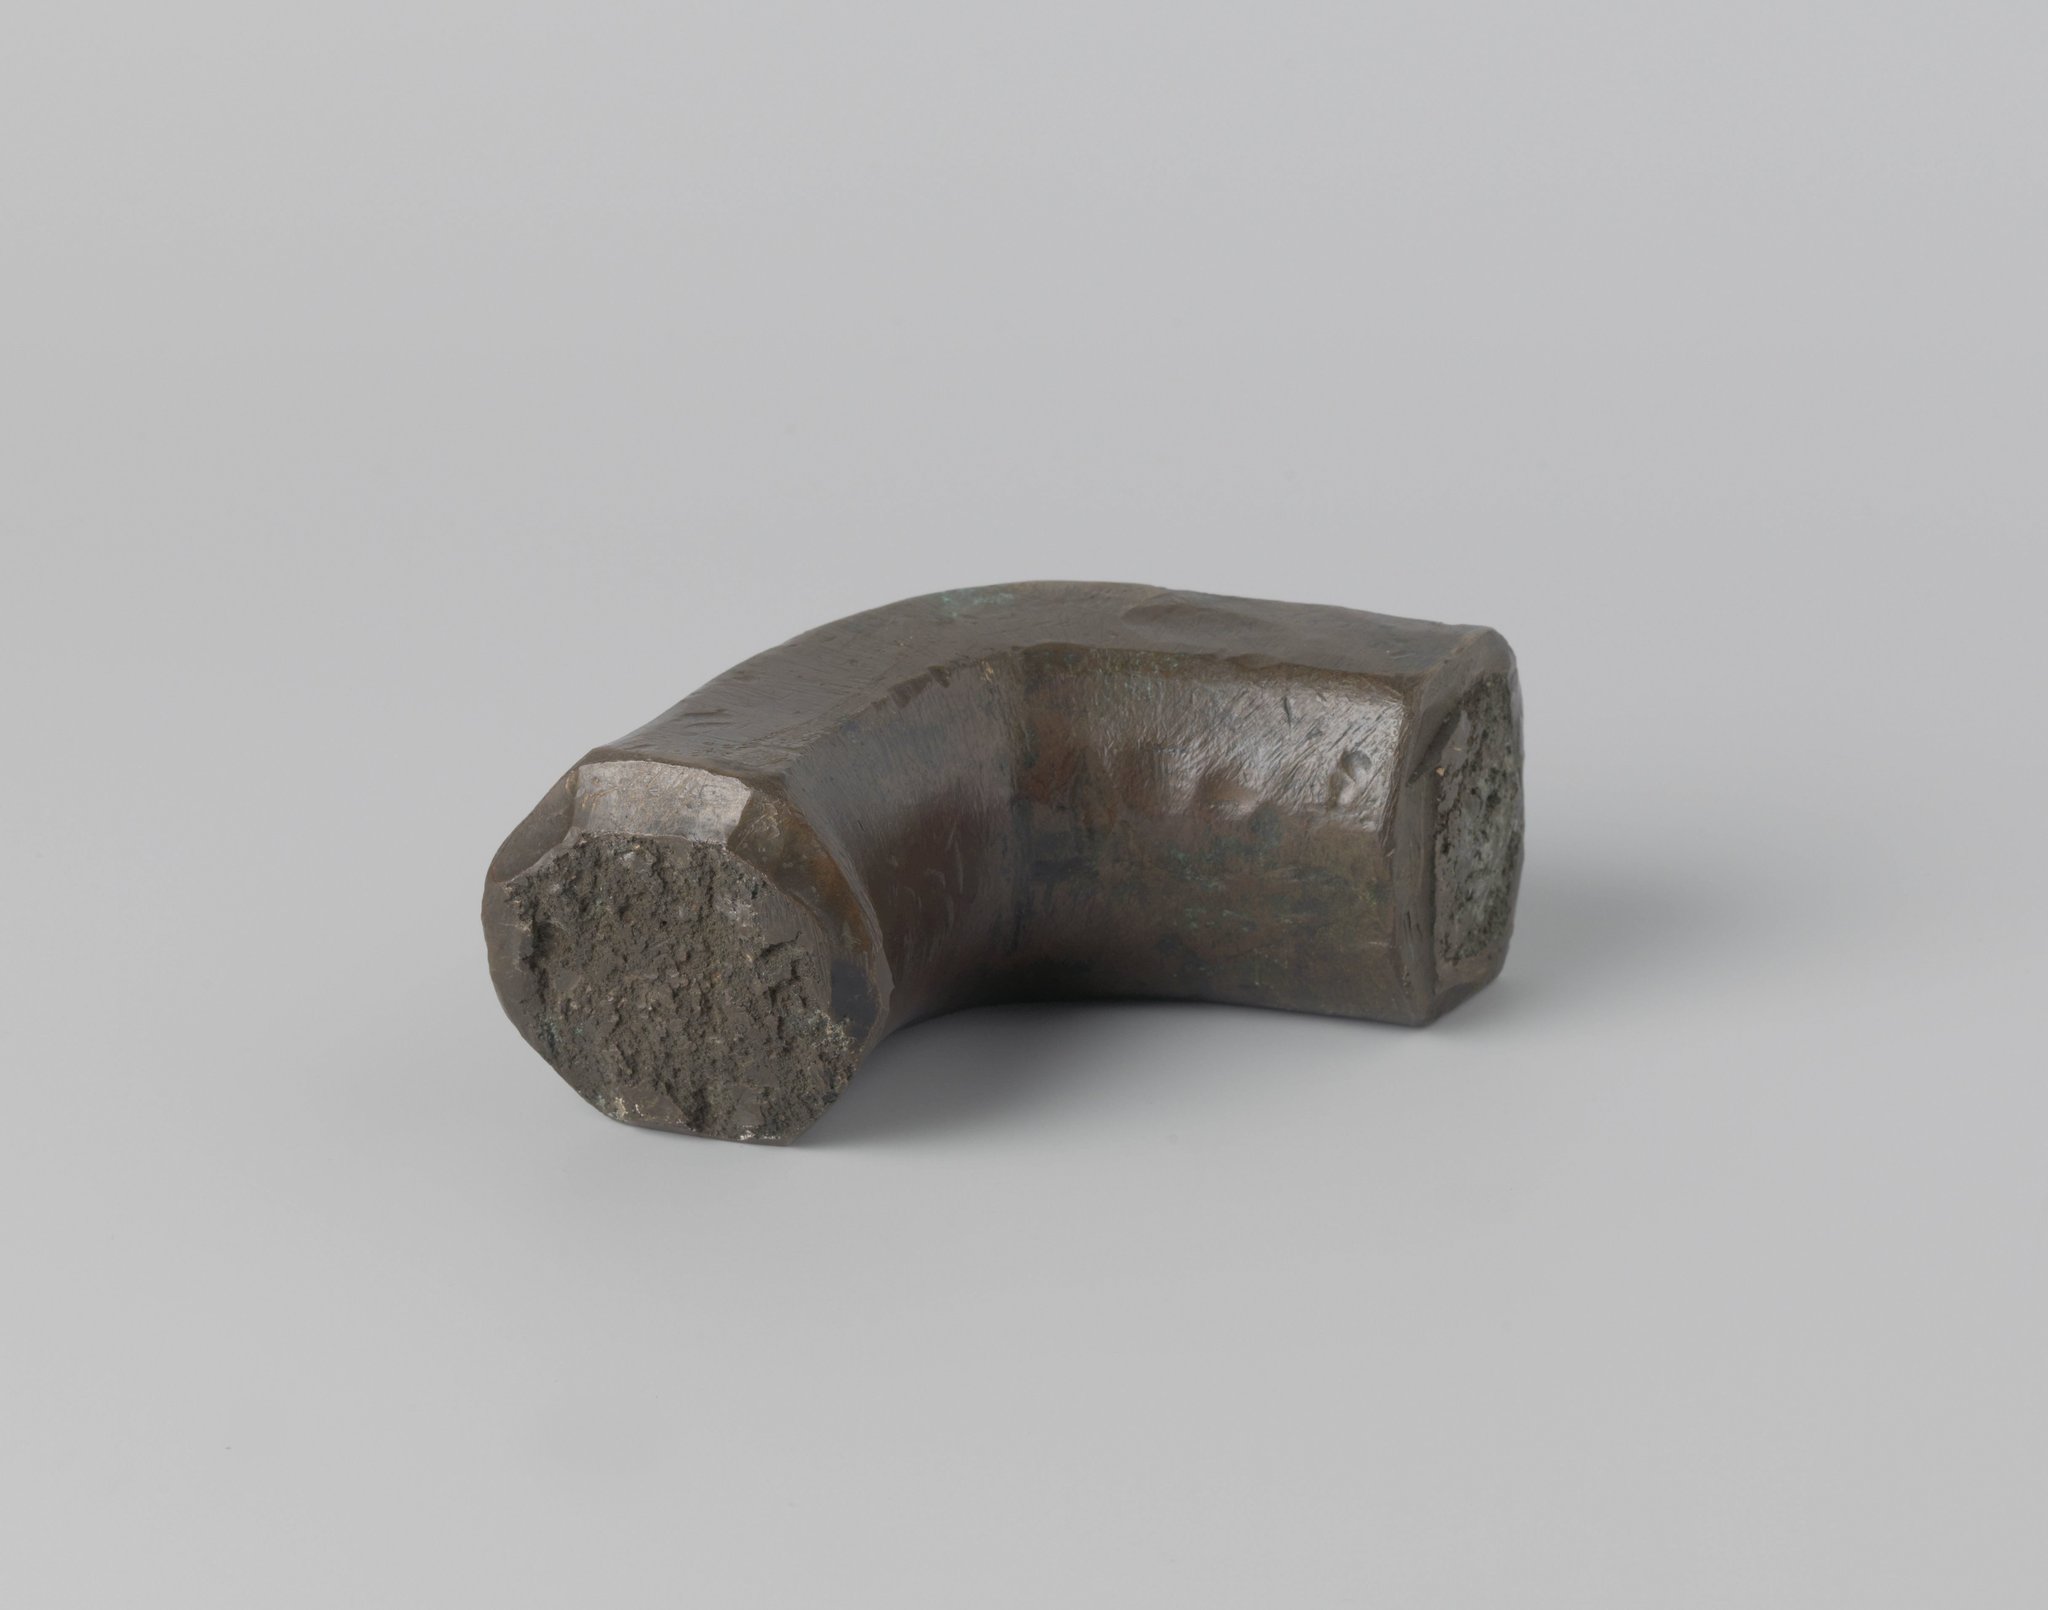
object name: sample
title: Metaalmonster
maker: Anonymous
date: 1850-1900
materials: copper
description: Gebogen metaalmonster, wellicht gebruikt om de buigzaamheid van koper te testen of te demonstreren.